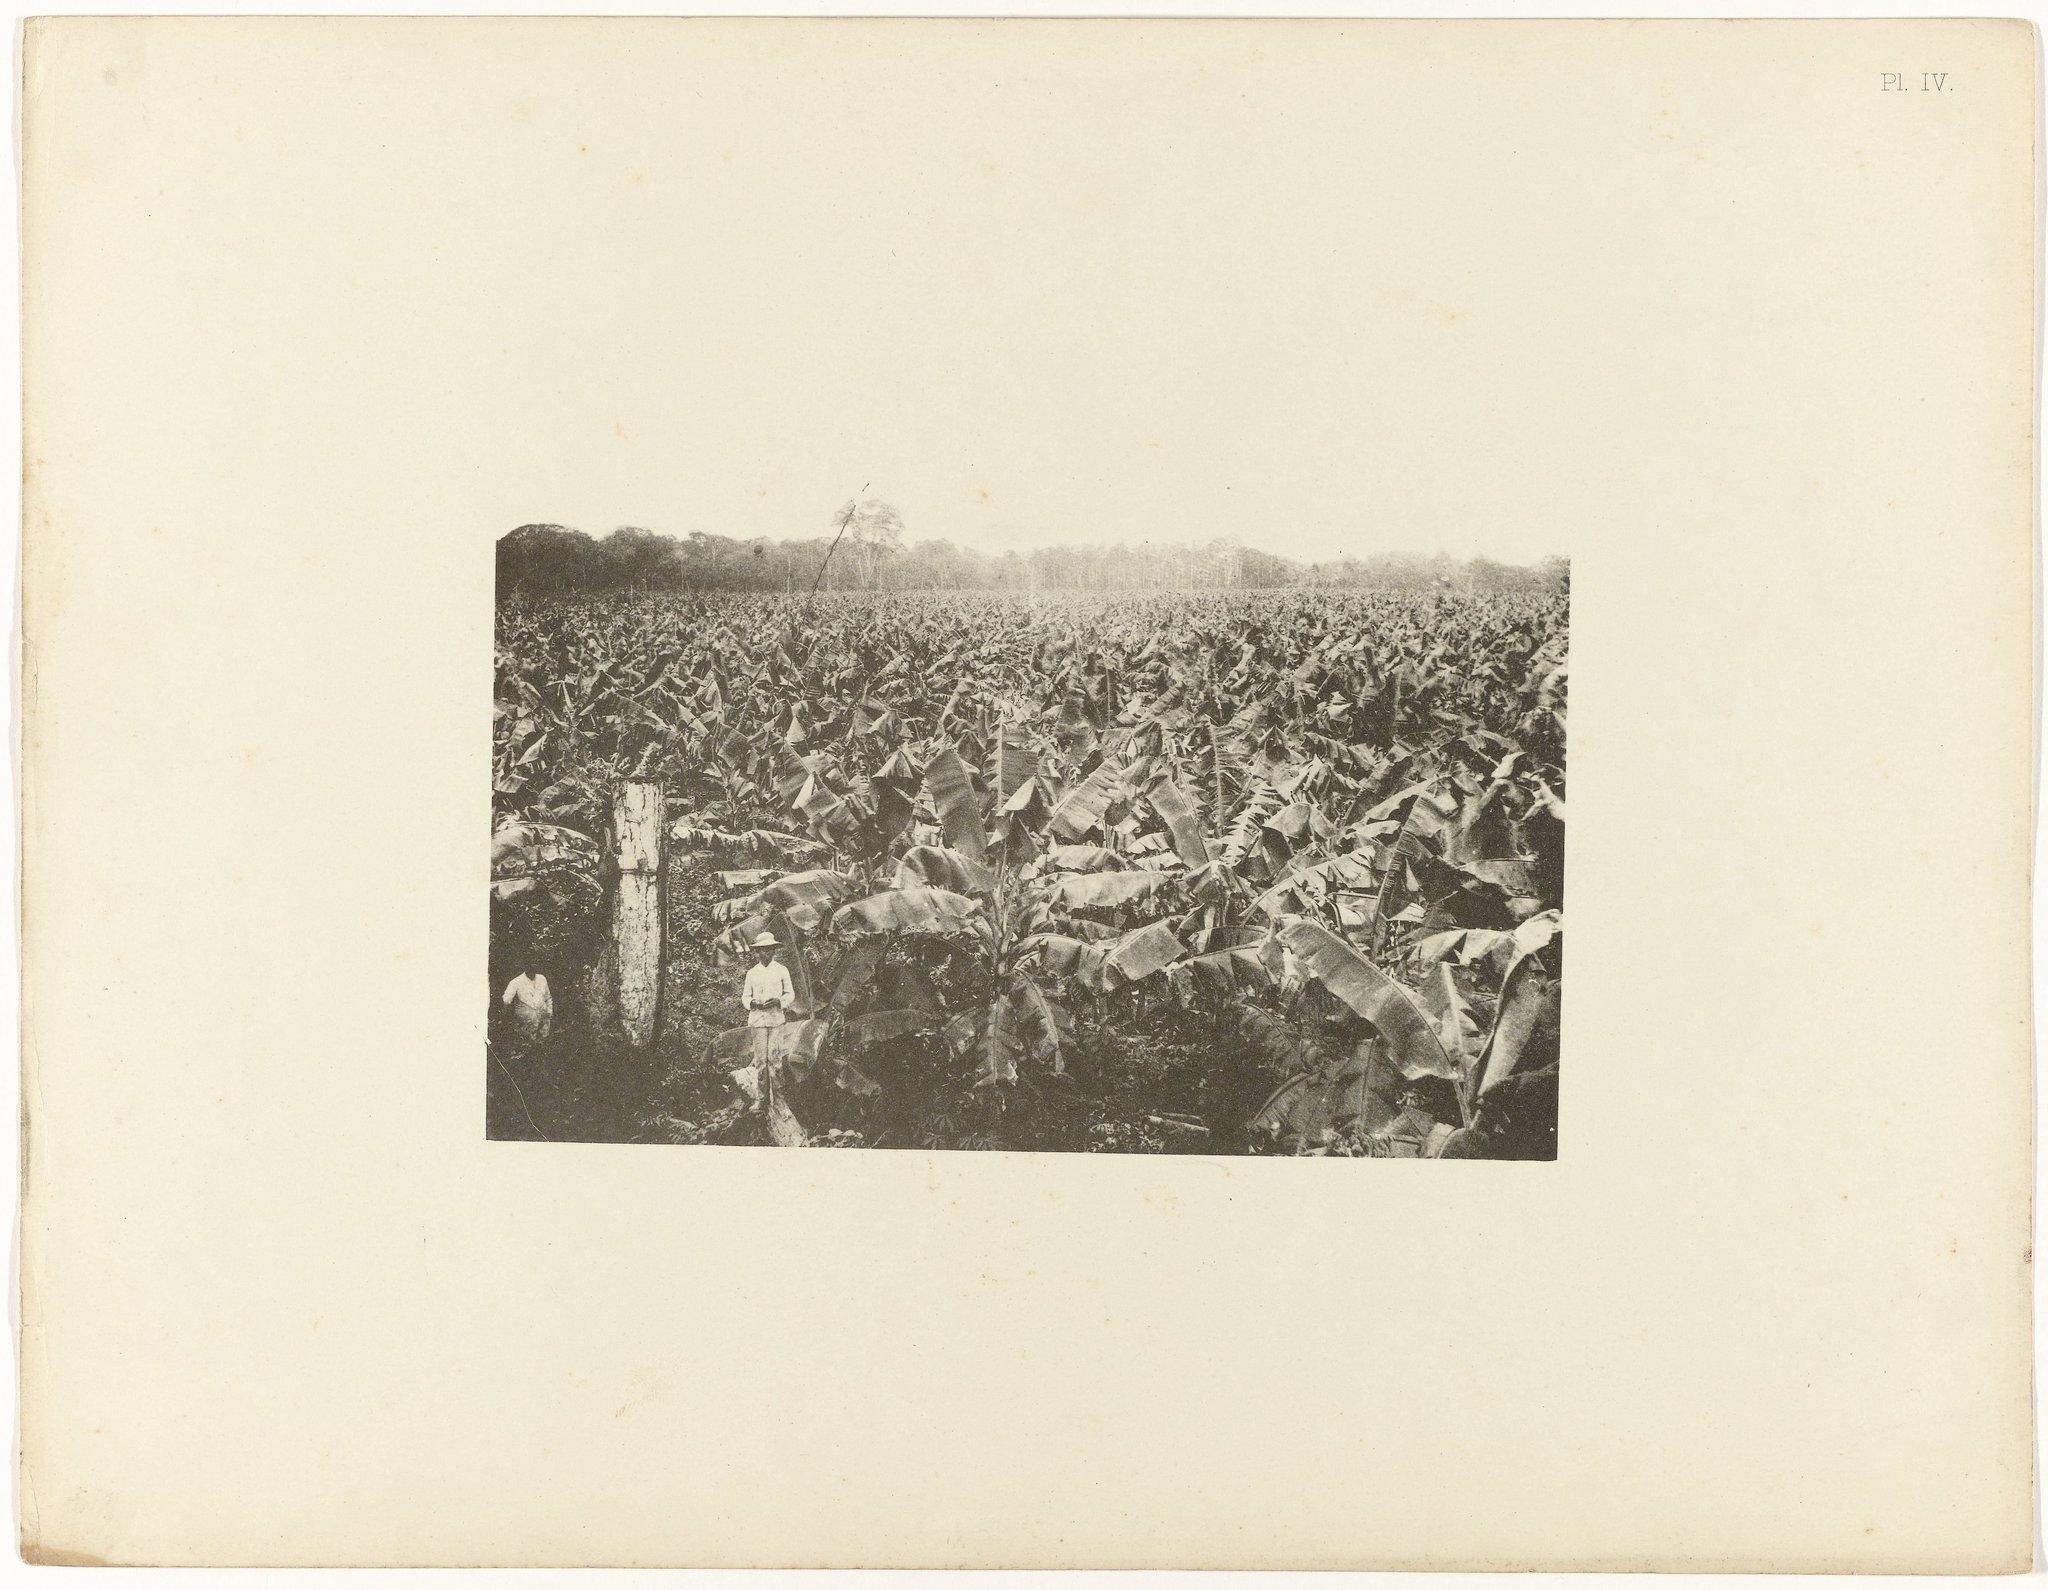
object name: photomechanical print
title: Bananenveld, Suriname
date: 1896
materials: paper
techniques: photograph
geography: haarlem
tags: fruits: banana, plants ~ agriculture, suriname